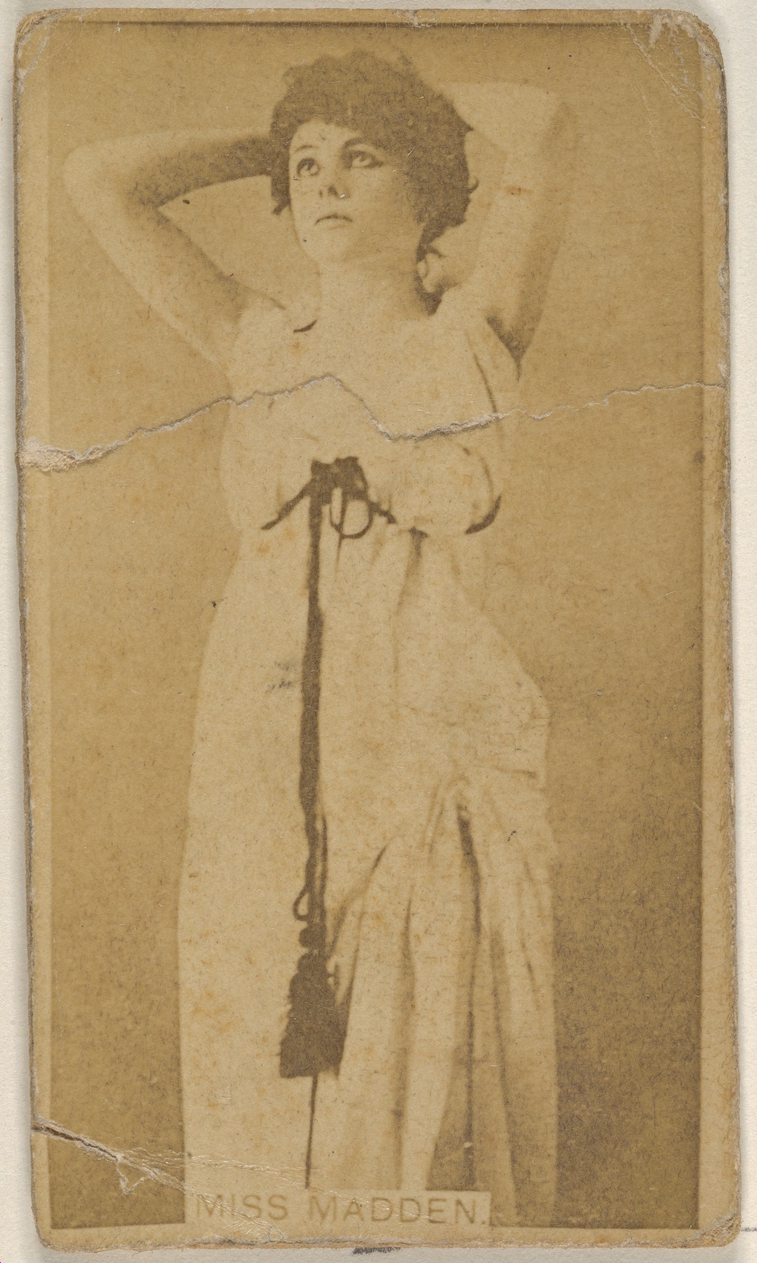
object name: photograph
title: Miss Madden, from the Actors and Actresses series (N45, Type 8) for Virginia Brights Cigarettes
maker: allen & ginter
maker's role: publisher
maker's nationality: american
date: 1888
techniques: albumen silver print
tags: portraits,women,actresses